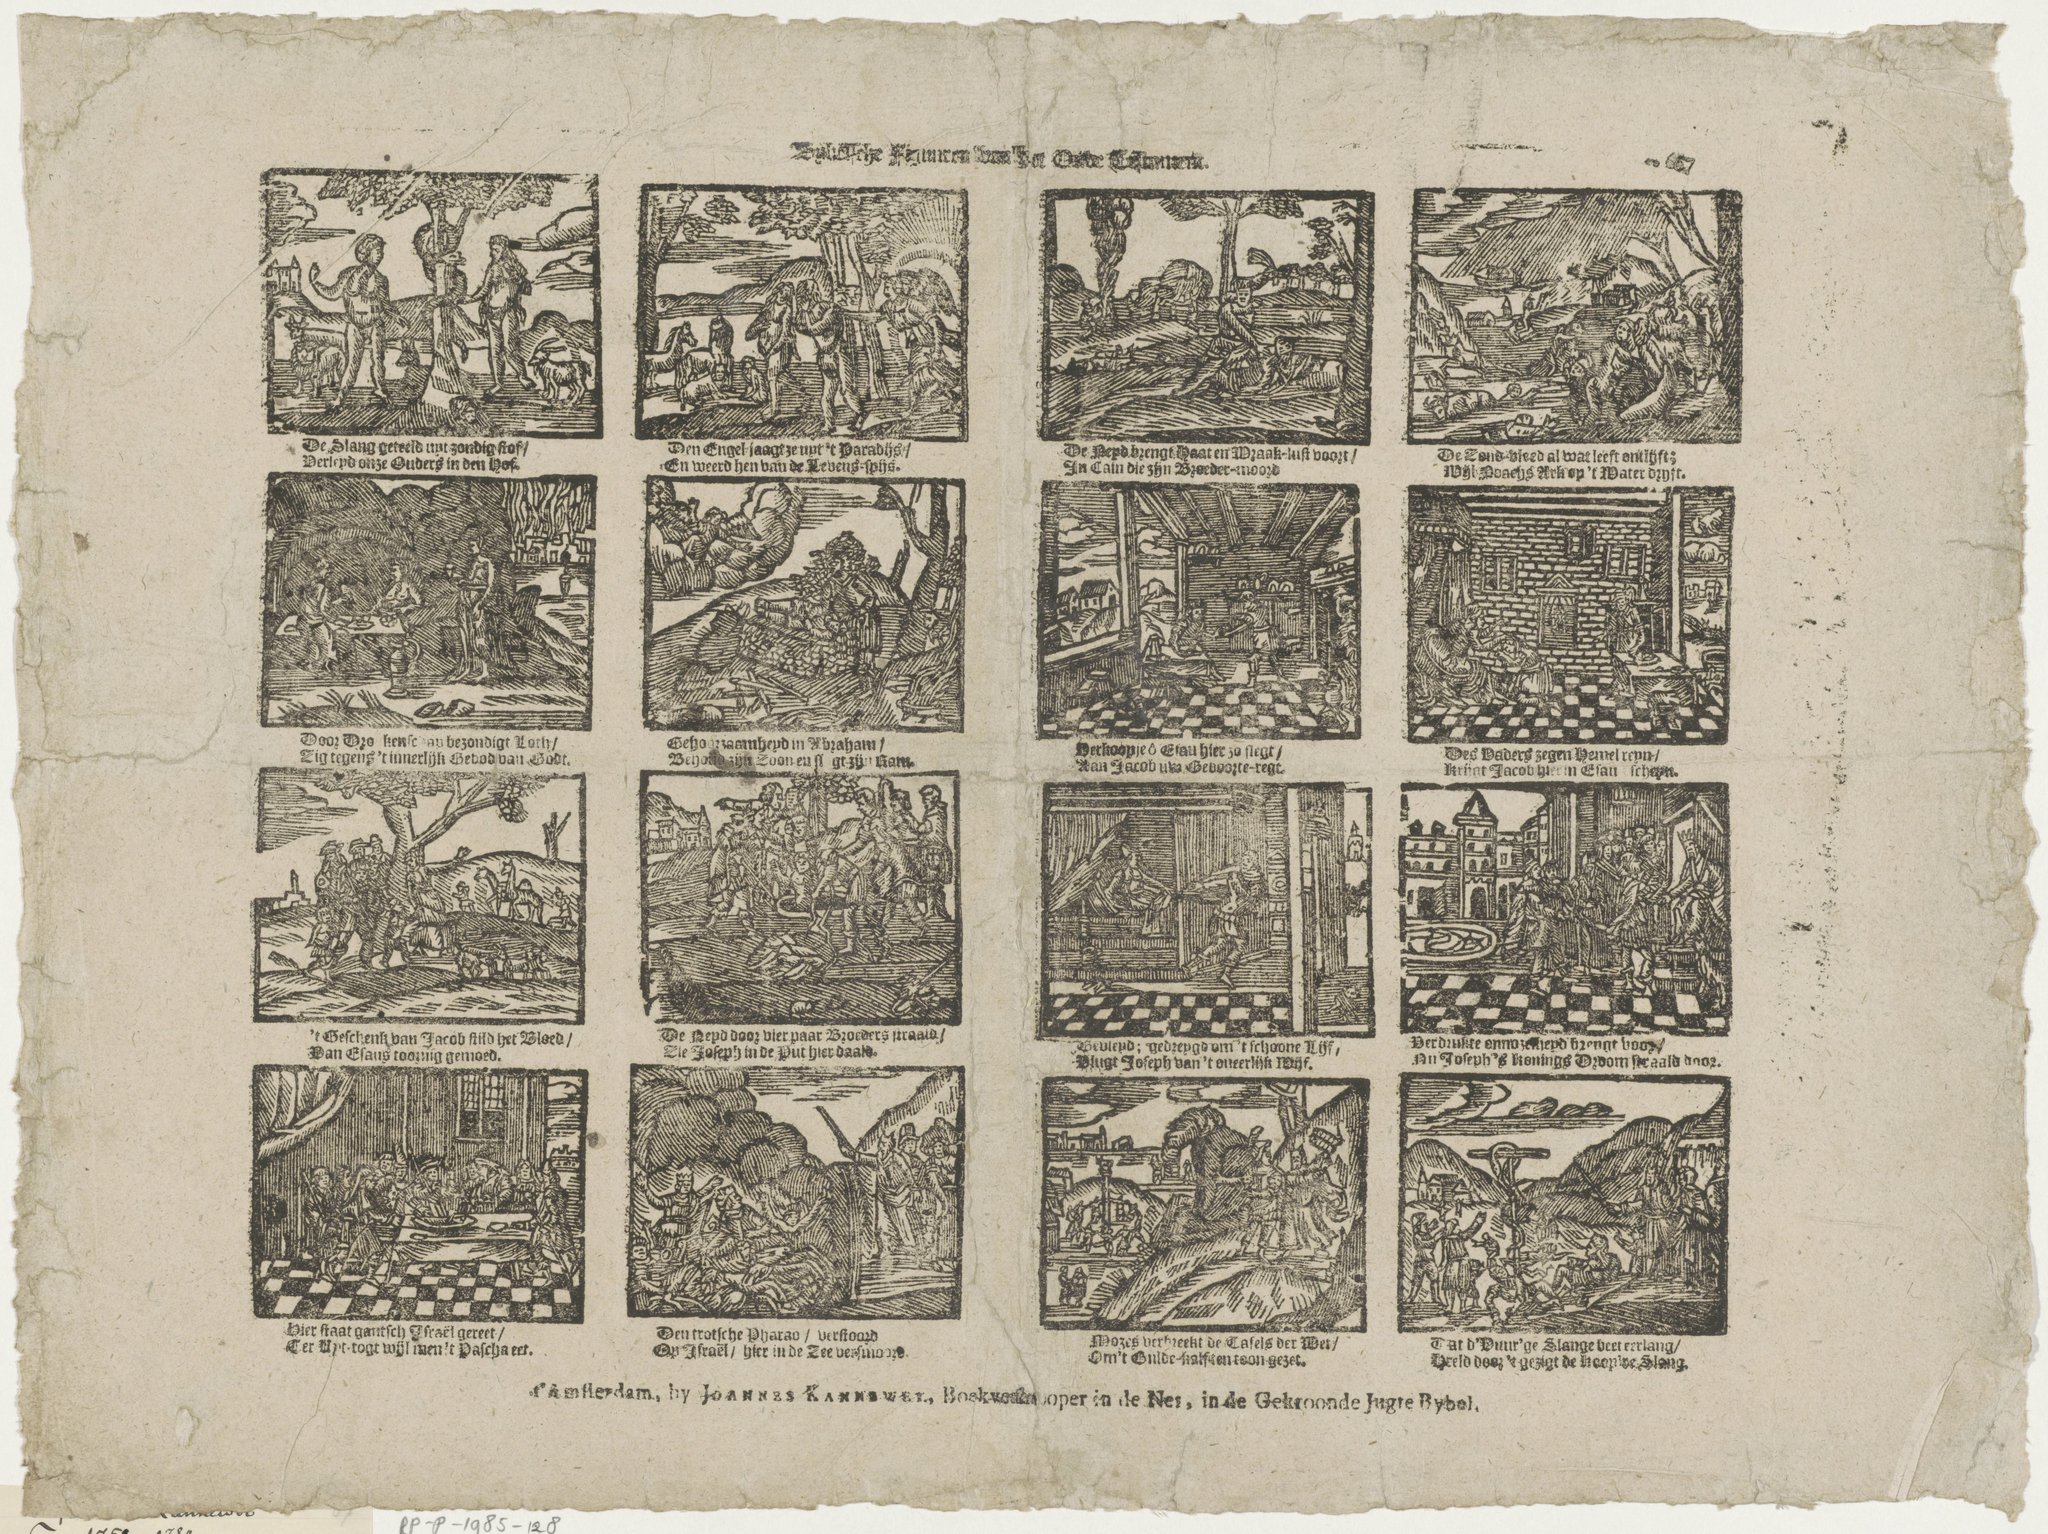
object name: popular print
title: Bijbelsche figuren van het Oude Testament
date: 1725-1780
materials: paper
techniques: letterpress printing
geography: amsterdam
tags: old testament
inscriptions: collector's mark: Lugt 2228, collector's mark: Lugt 2760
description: Blad met 16 voorstellingen van verhalen uit het Oude Testament, waaronder Adam en Eva die worden verdreven uit het paradijs en Abraham die Isaak offert. Onder elke afbeelding een tweeregelig vers. Genummerd rechtsboven: *67.